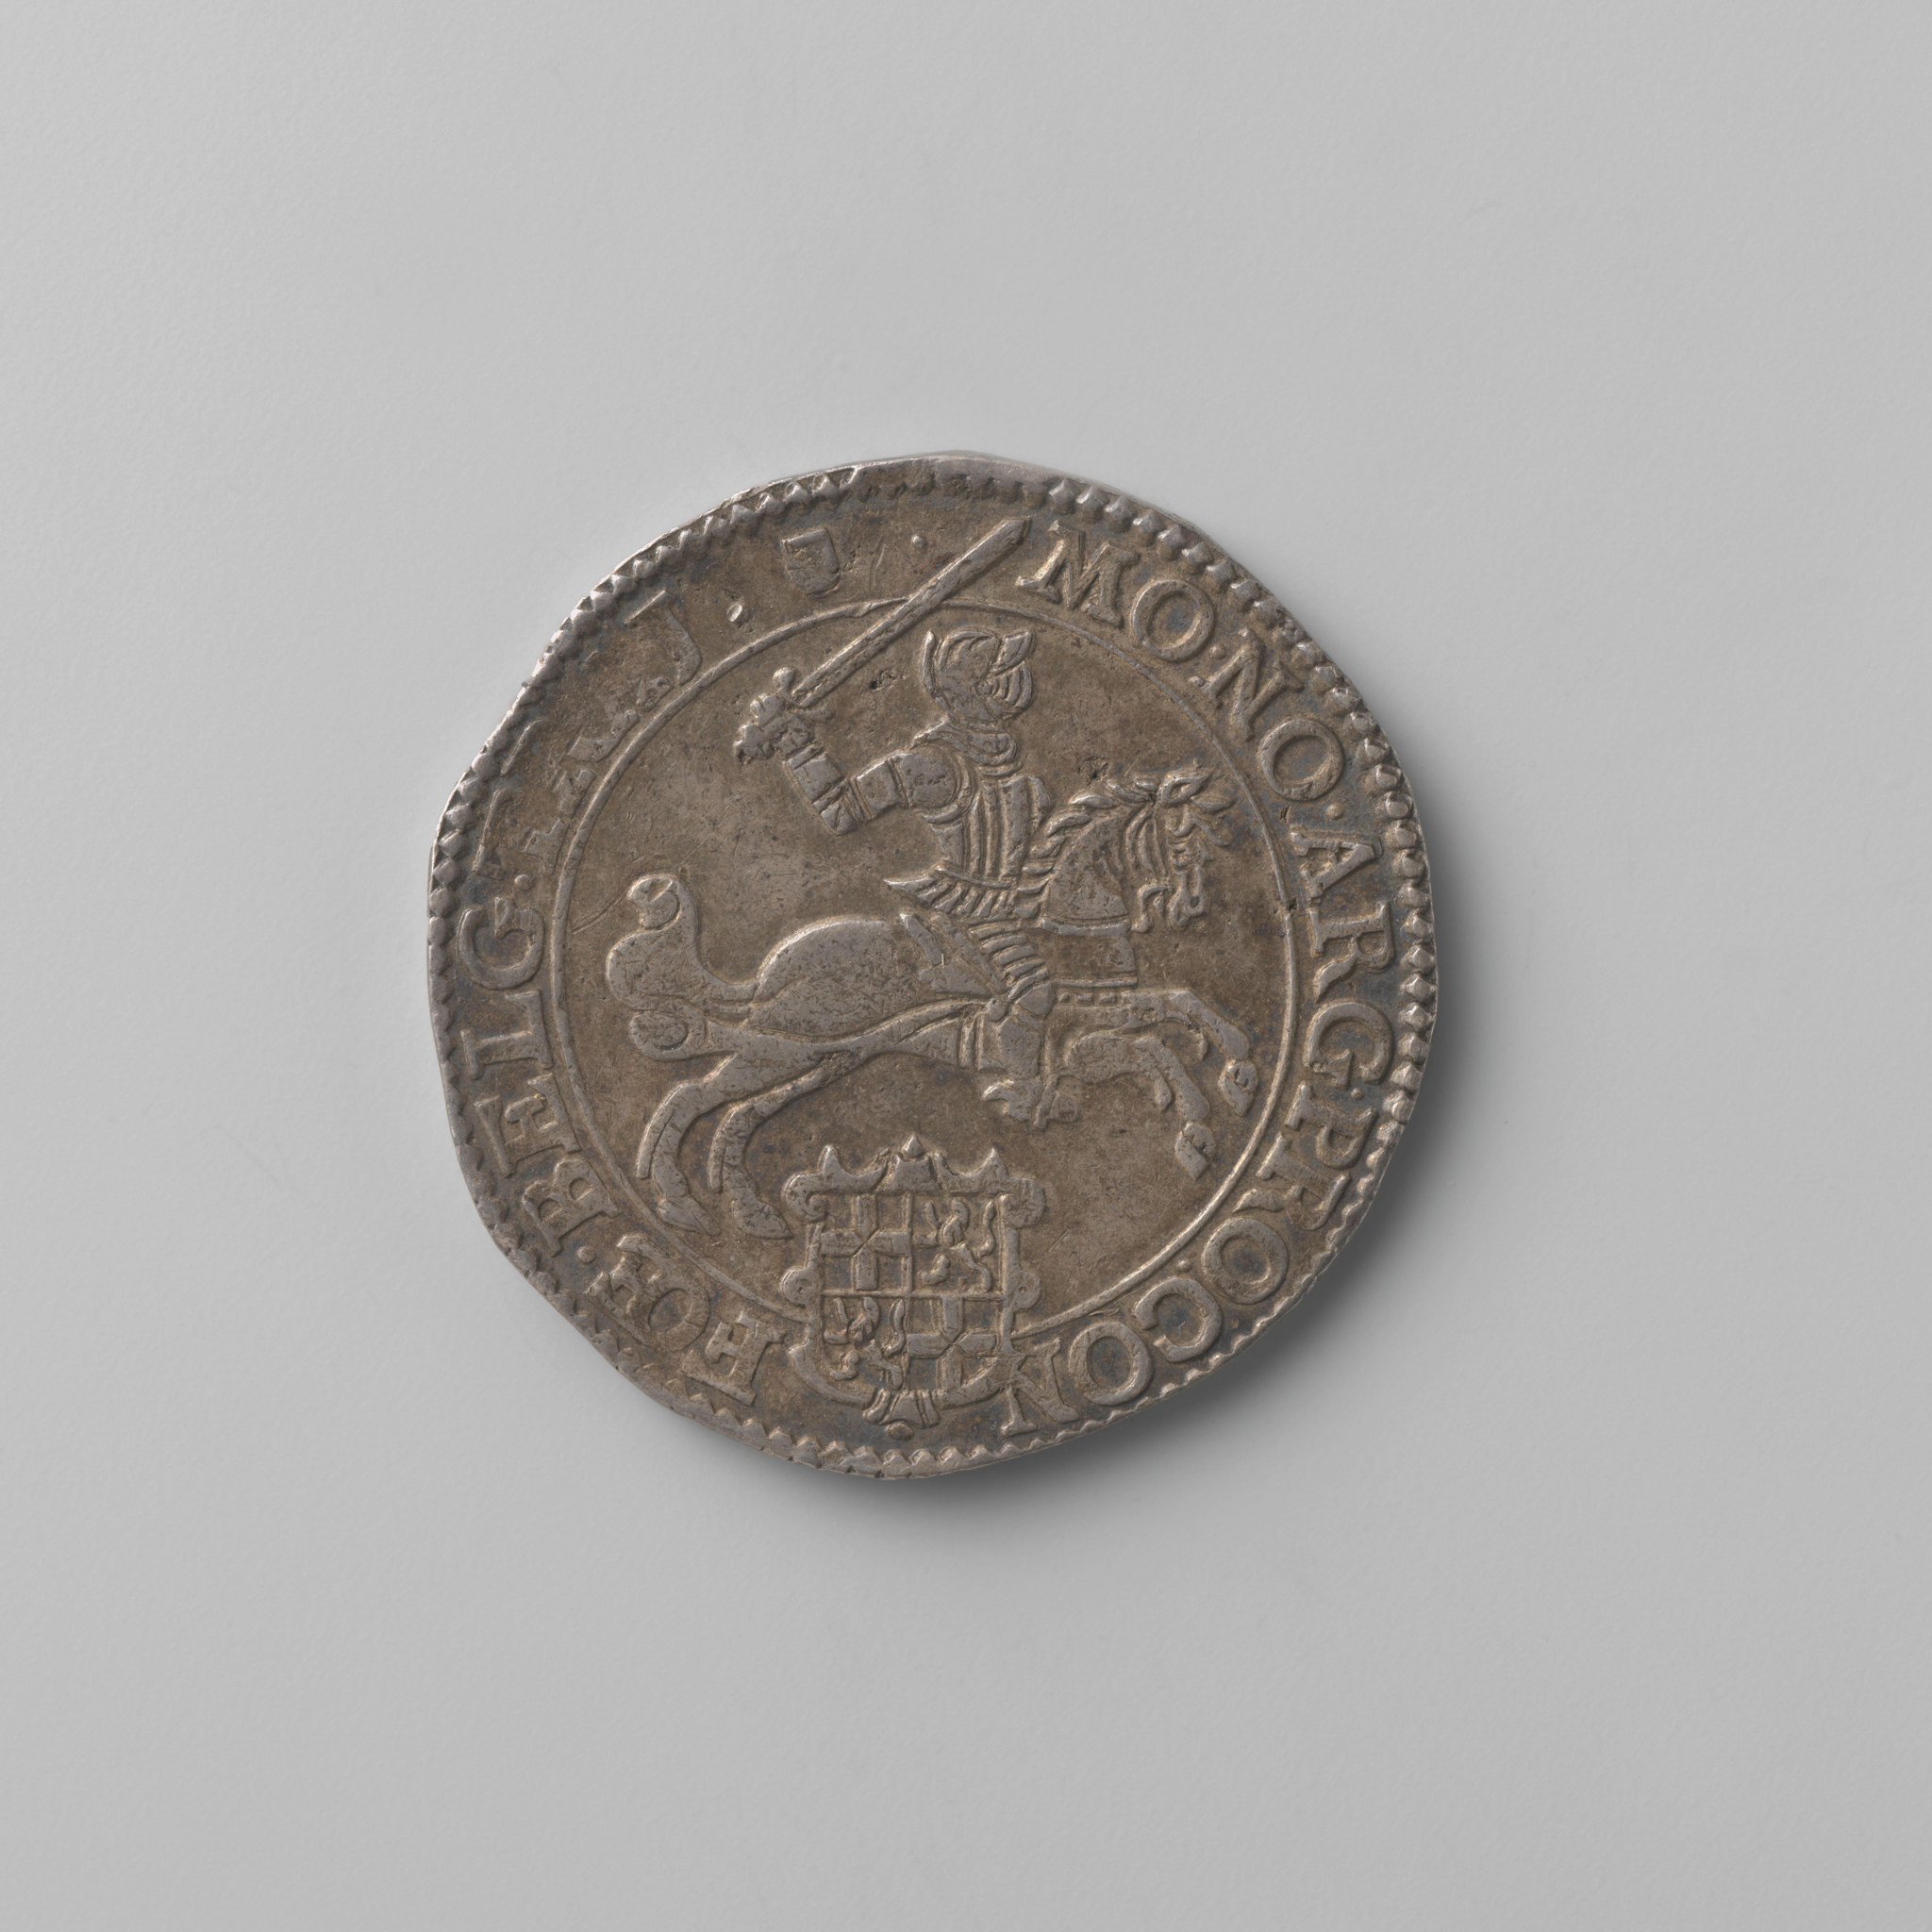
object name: coin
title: Utrecht, halve zilveren rijder, 1667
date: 1667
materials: silver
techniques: striking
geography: utrecht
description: Zilveren munt. Voorzijde: ridder te paard naar rechts met in rechterhand zwaard. Onder paard versierd wapenschild van Utrecht. Keerzijde: door twee gekroonde leeuwen gehouden generaliteitswapenschild. Jaartal boven kroon in omschrift.